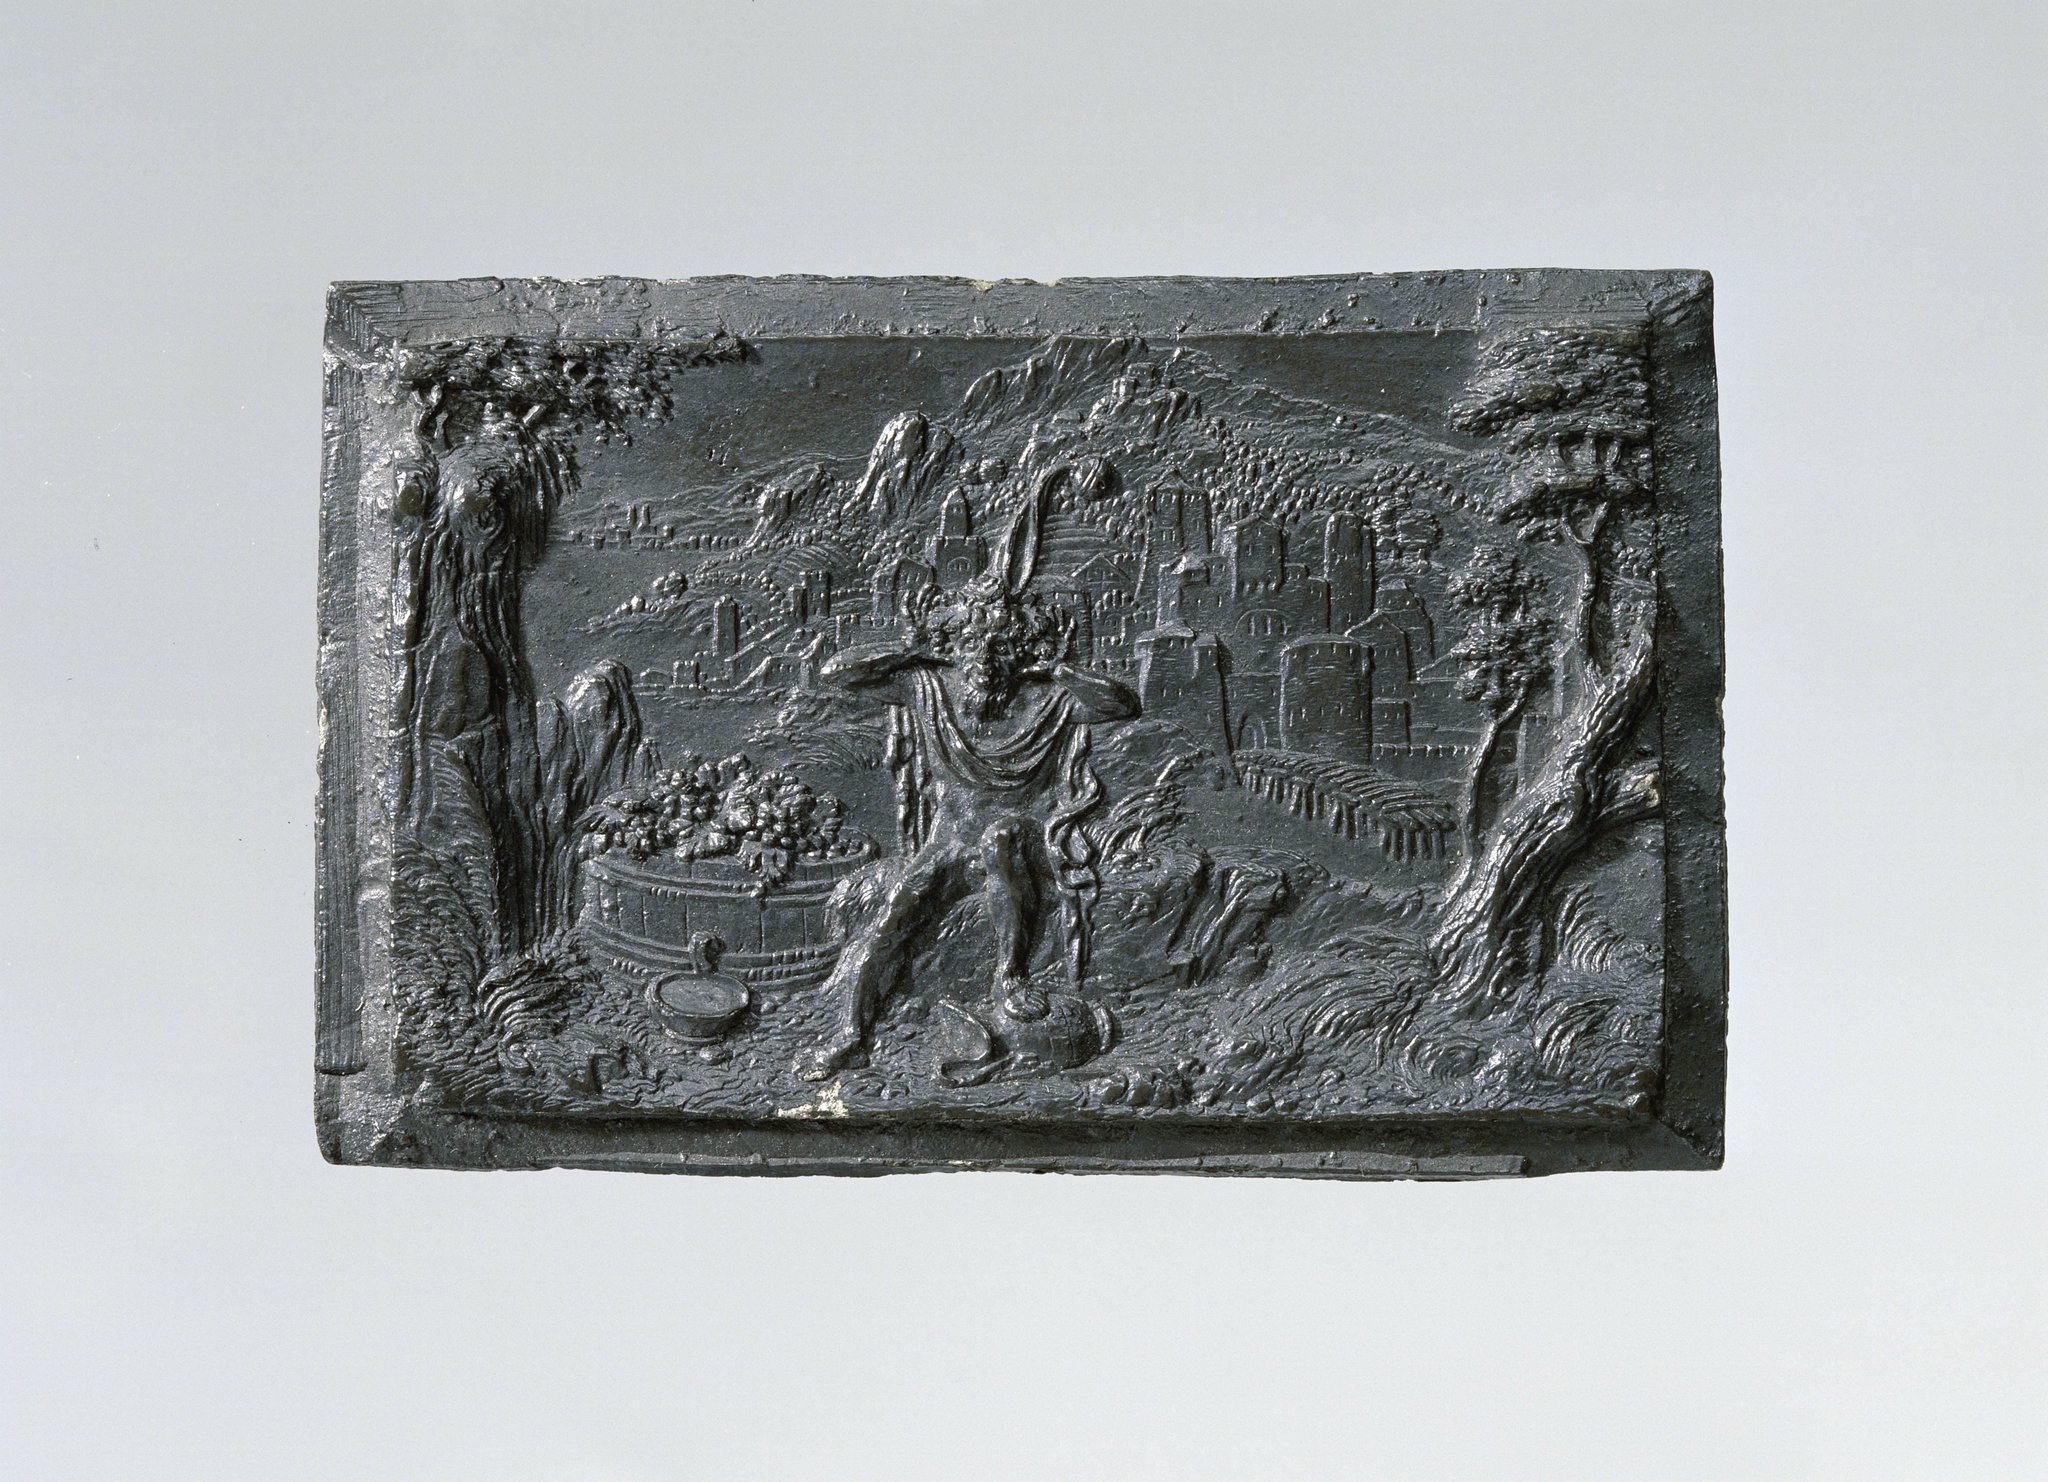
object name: plaque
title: Zeven gevolgen van dronkenschap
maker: peter flötner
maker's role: print maker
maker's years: 1485-1546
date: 1525-1550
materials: lead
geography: nuremberg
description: Rechthoekige, loden, plaquette met afgeschuinde randen. Een oude man, het hoofd bekranst met wijnranken, zit naast een vat met druiven. Hij houdt de beide handen met gespreide vingers achter de oren. Een slip, waaraan een narrenbel gebonden is, waait achter zijn hoofd omhoog. In het landschap een stad; bergen op de achtergrond.